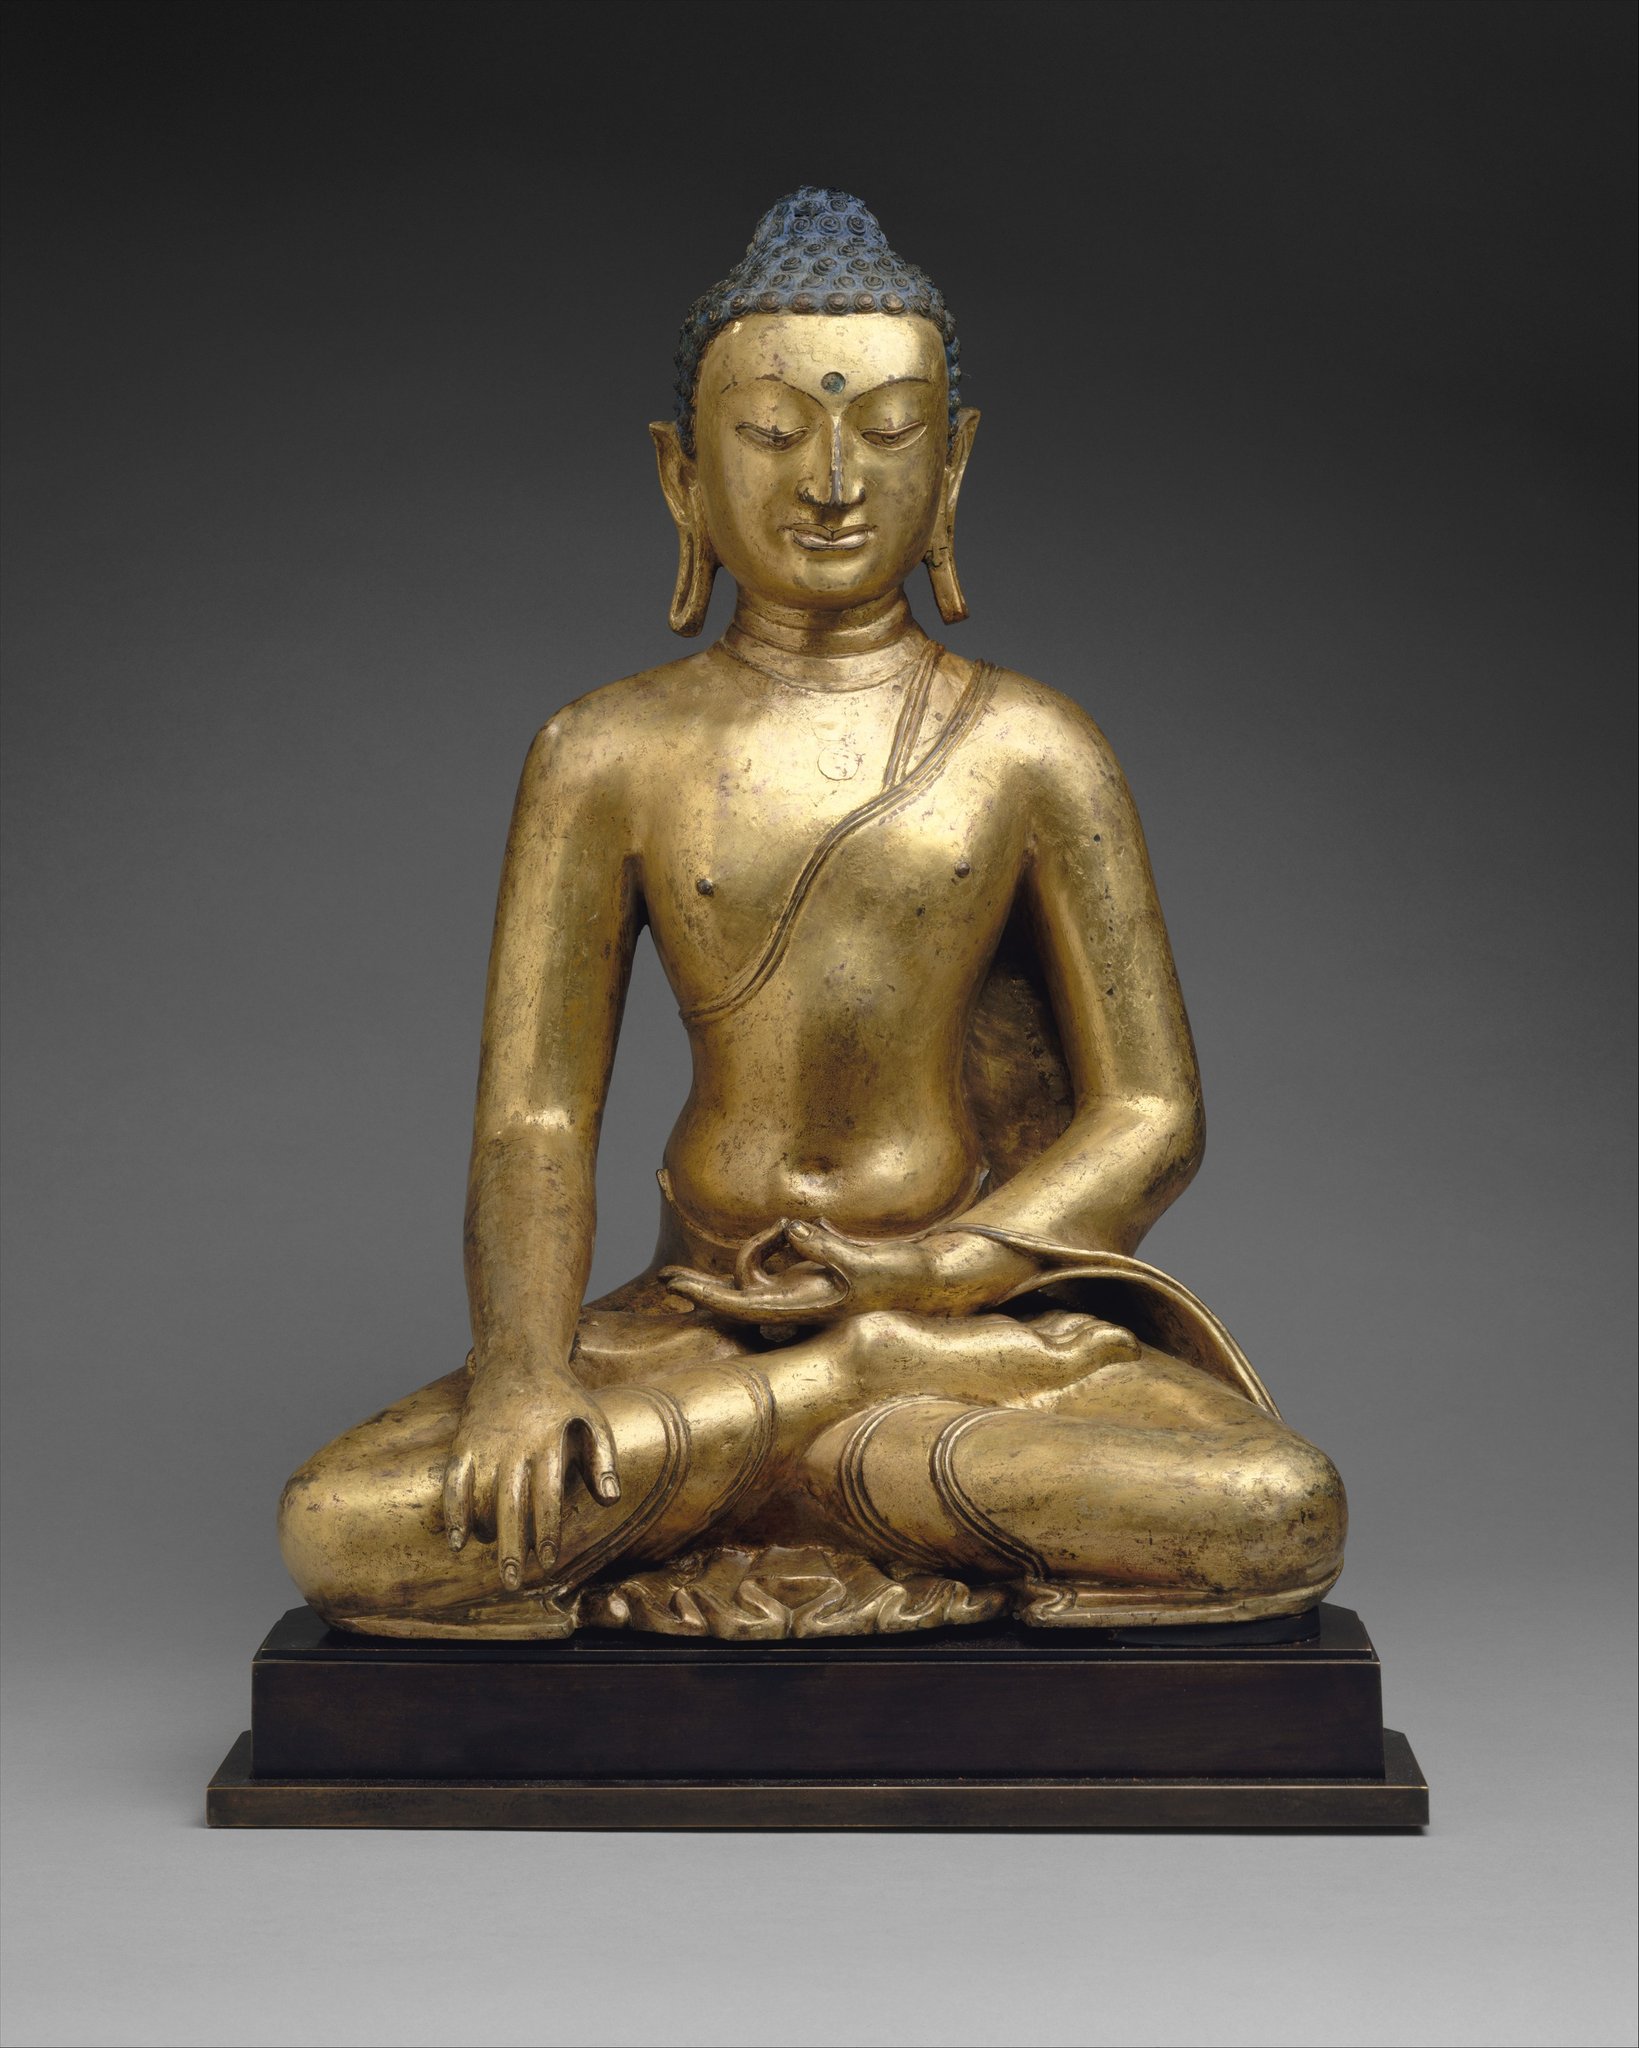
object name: figure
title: Buddha Shakyamuni or Akshobhya, the Buddha of the East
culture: tibetan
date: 1001-1200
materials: copper gilt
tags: buddhism,buddha,shakyamuni